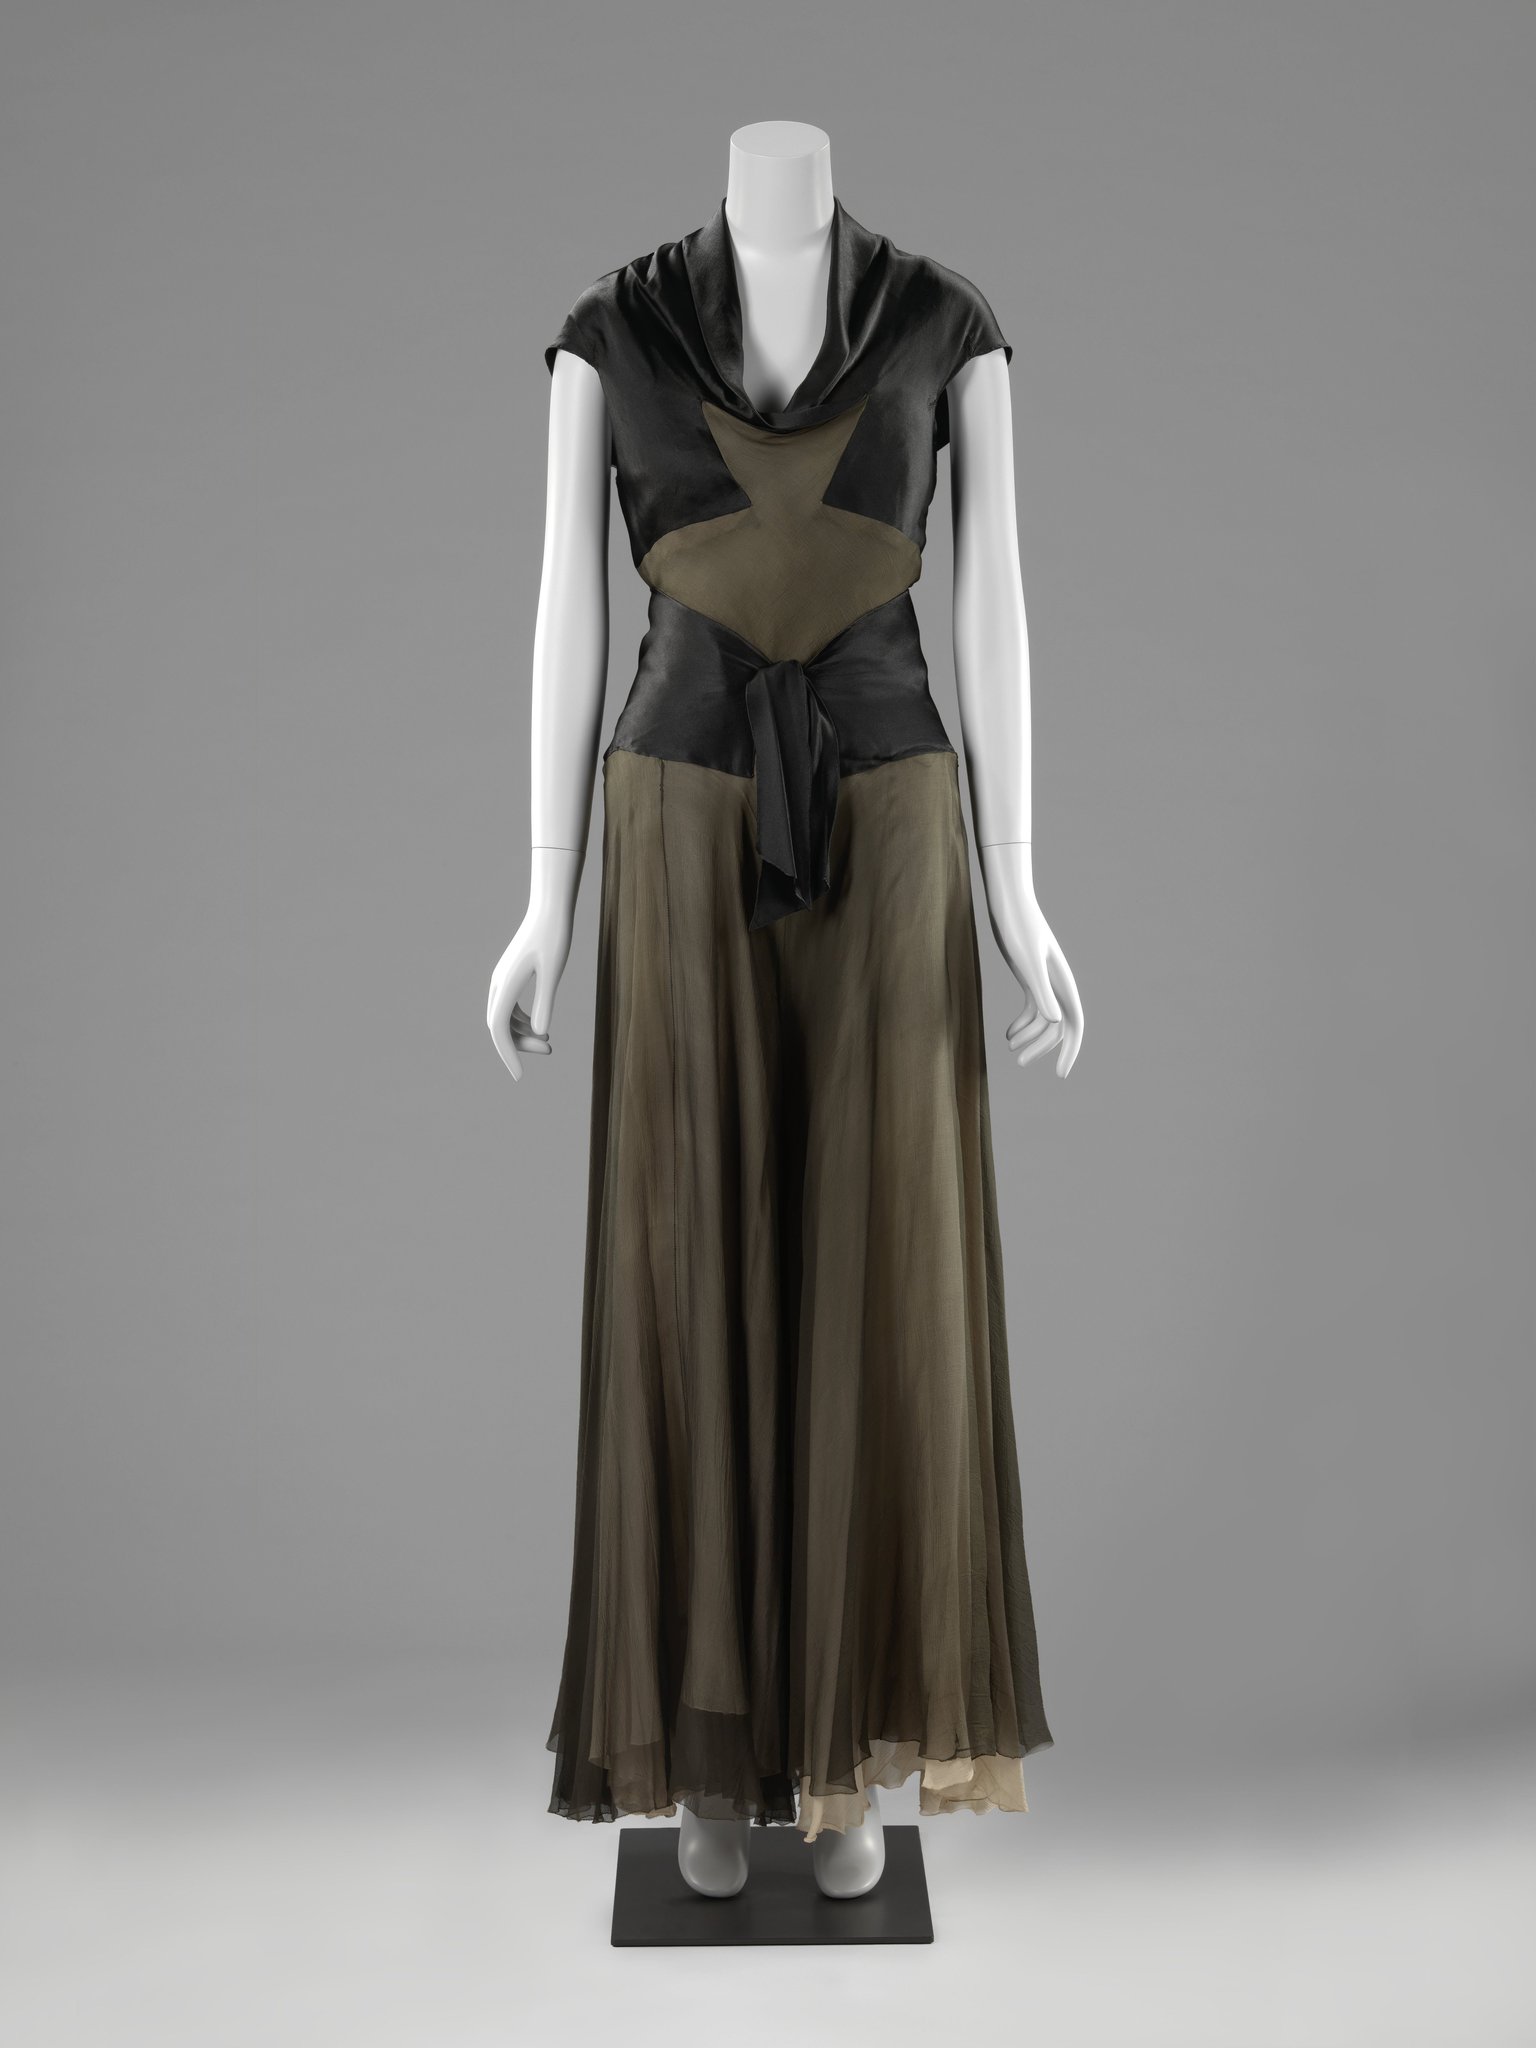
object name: loungewear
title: Lounging Pyjamas with Wide Legs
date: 1930-1935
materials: textile, silk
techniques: weave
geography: paris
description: Mrs Brusse wore these pyjamas as an outfit to receive guests. The wide legs create the illusion of being a skirt. As a result, the ensemble exudes the aura of an evening gown. It was made in Brussels after a design by the French couturière Madeleine Vionnet, who was famous for her ingenious patterns.